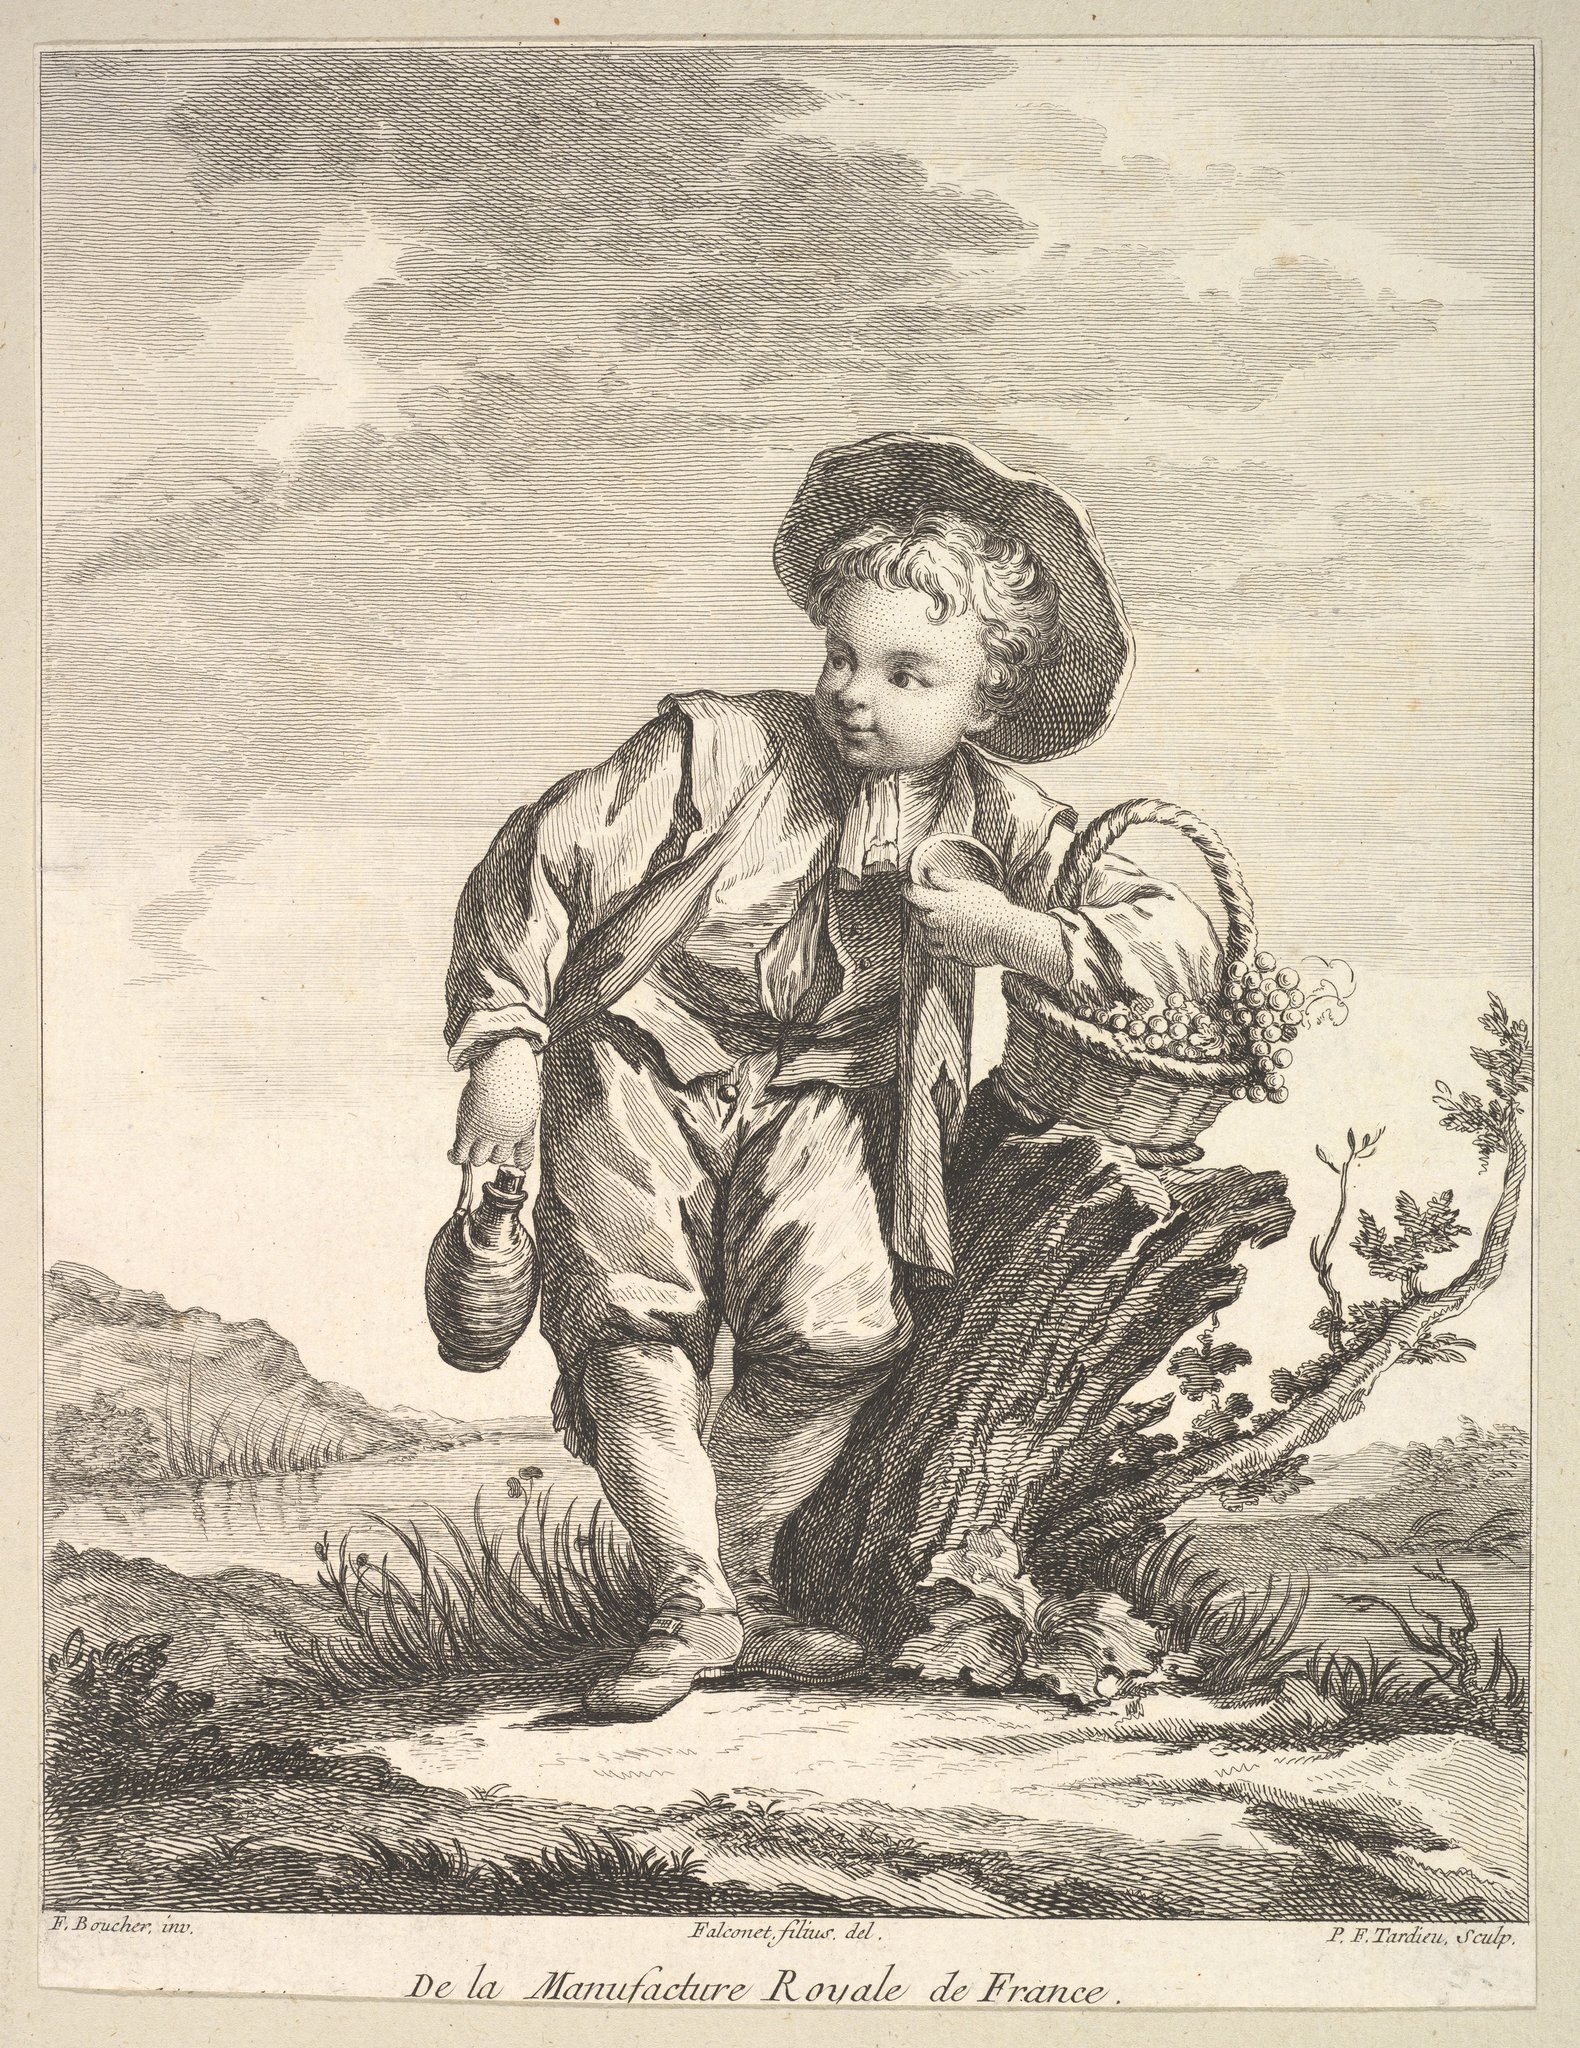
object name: collection ornament architecture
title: Little boy holding a basket of grapes, from Deuxième Livre de Figures d'après les porcelaines de la Manufacture Royale de France (Second Book of Figures after porcelains from the Manufacture Royale de France)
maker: pierre françois tardieu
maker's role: artist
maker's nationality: french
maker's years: 1711-1771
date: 1757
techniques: engraving, etching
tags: grapes,boys